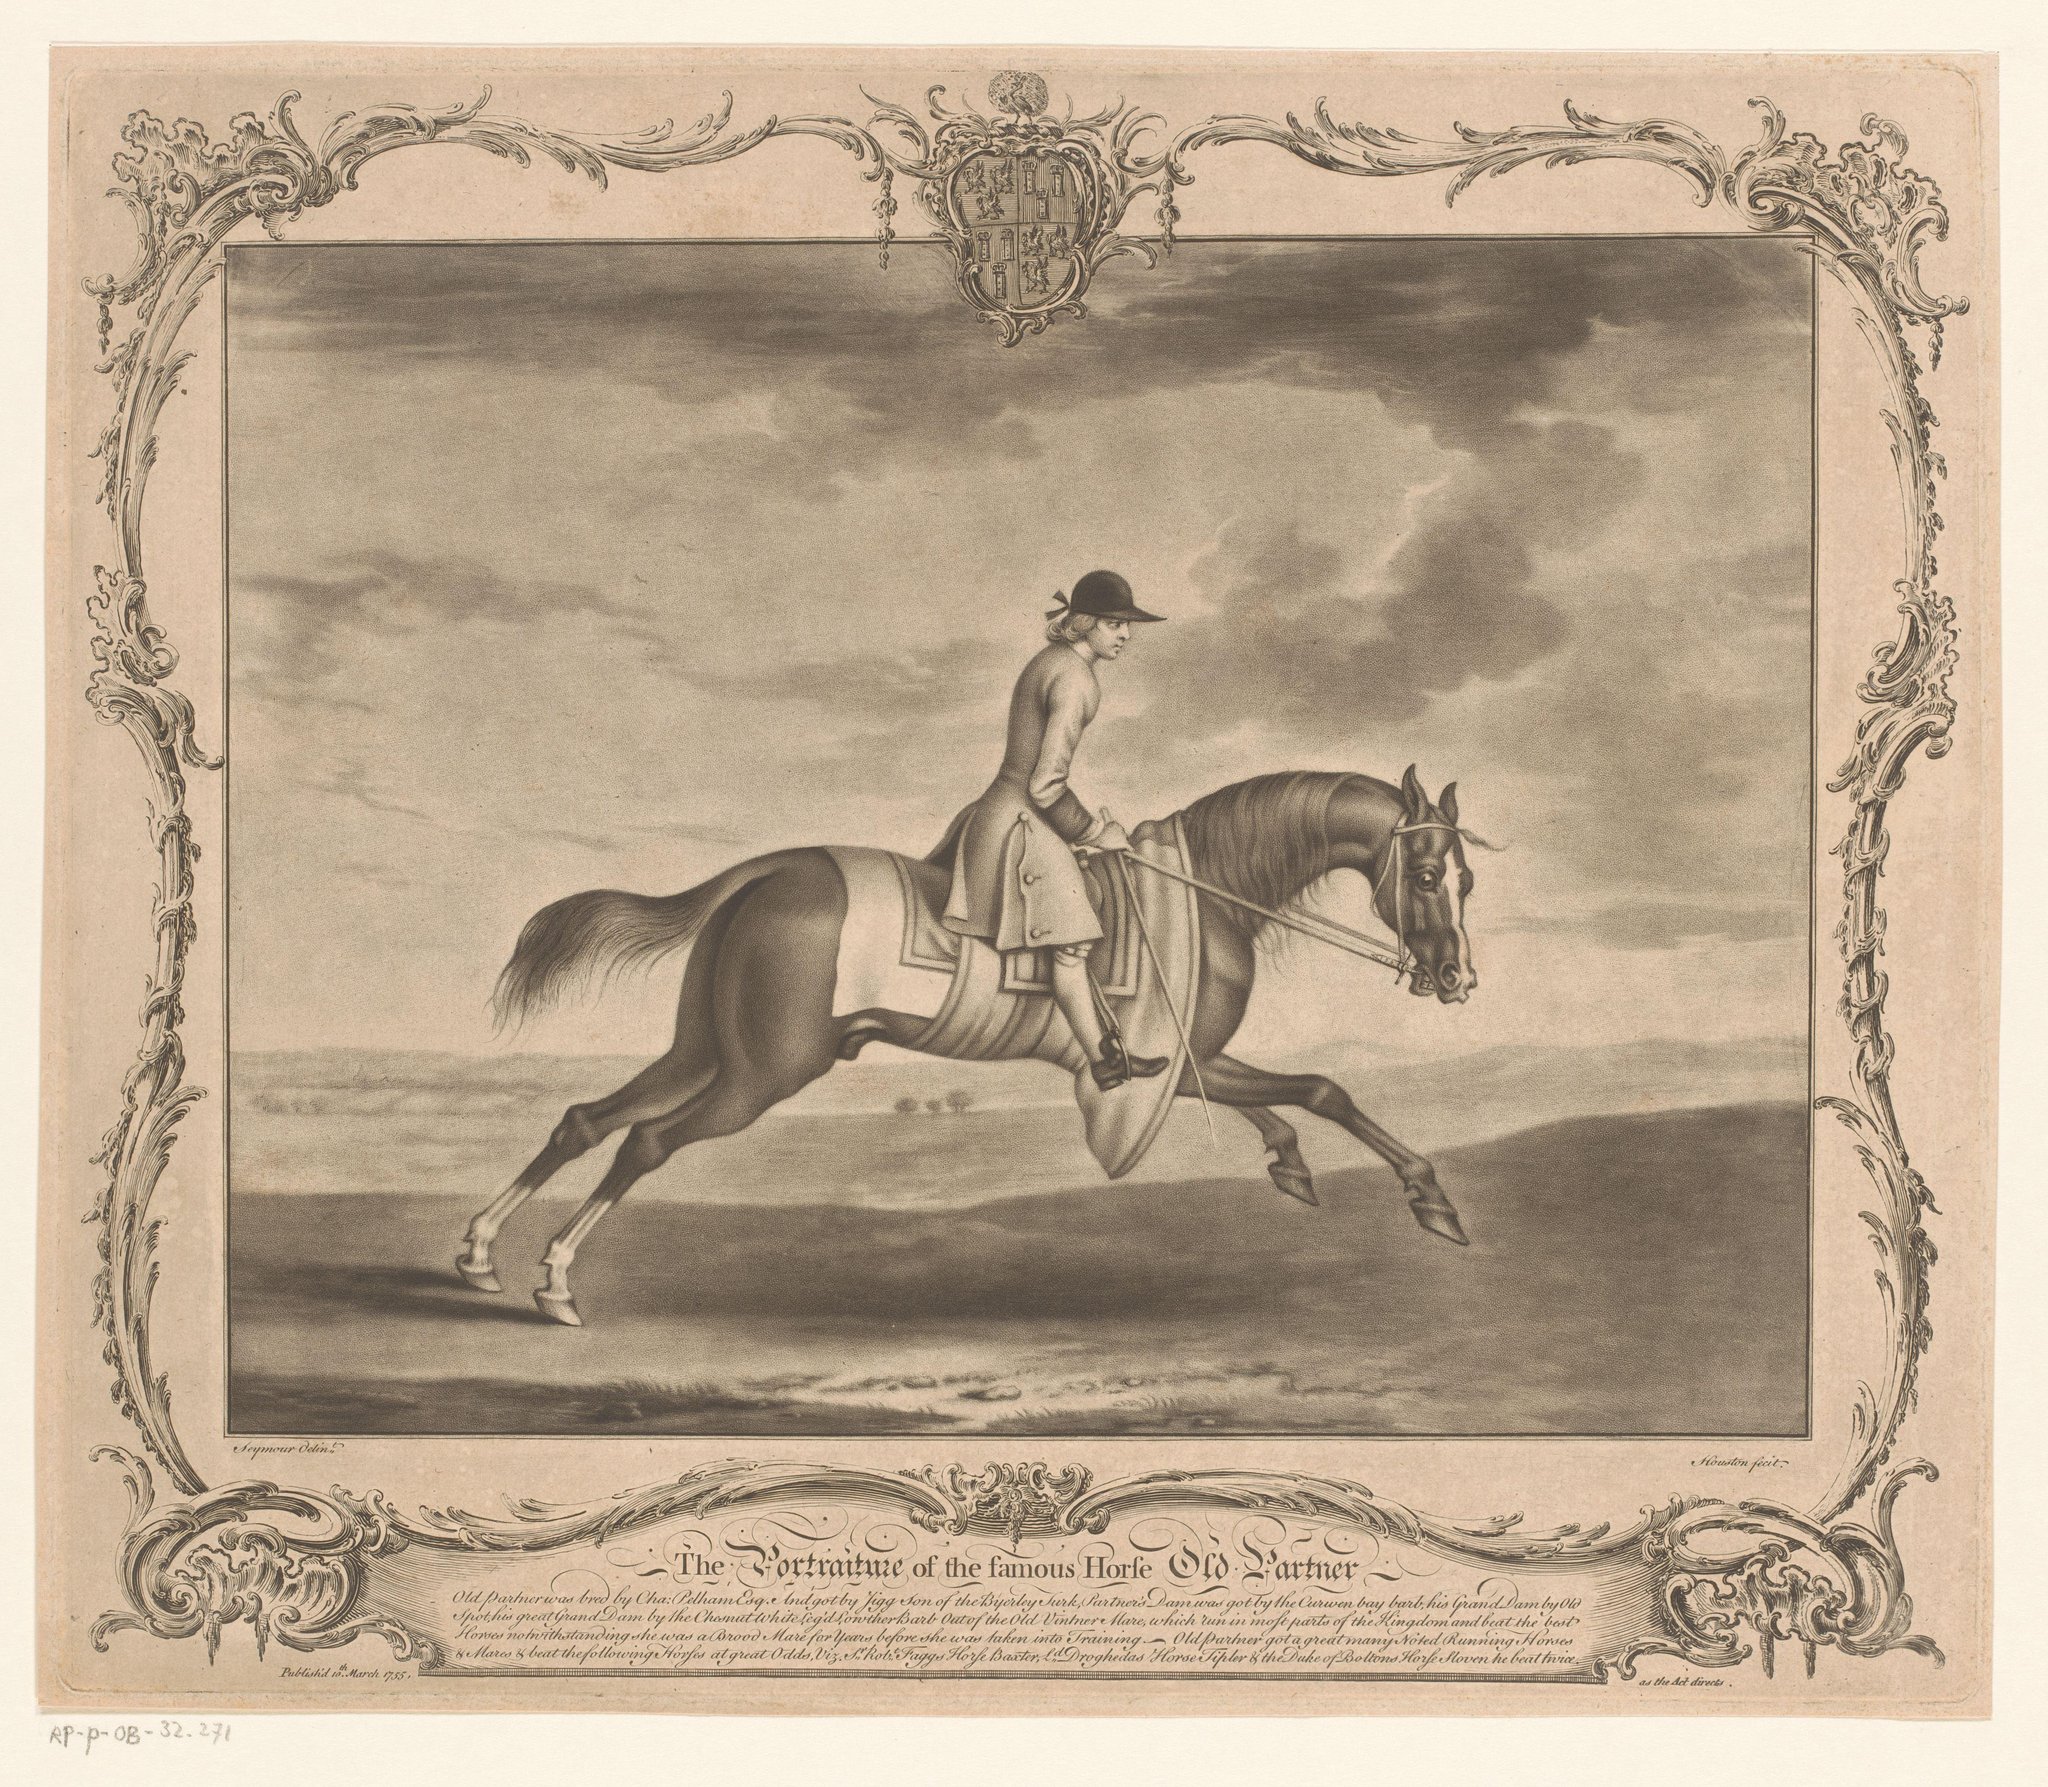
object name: print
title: The Portraiture of the famous horse Old Partner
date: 1755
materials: paper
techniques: etching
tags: horse-racing, jockey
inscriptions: collector's mark: Lugt 2228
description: Tekst in het Engels in de ondermarge. De omkadering bevat een wapenschild met herten.